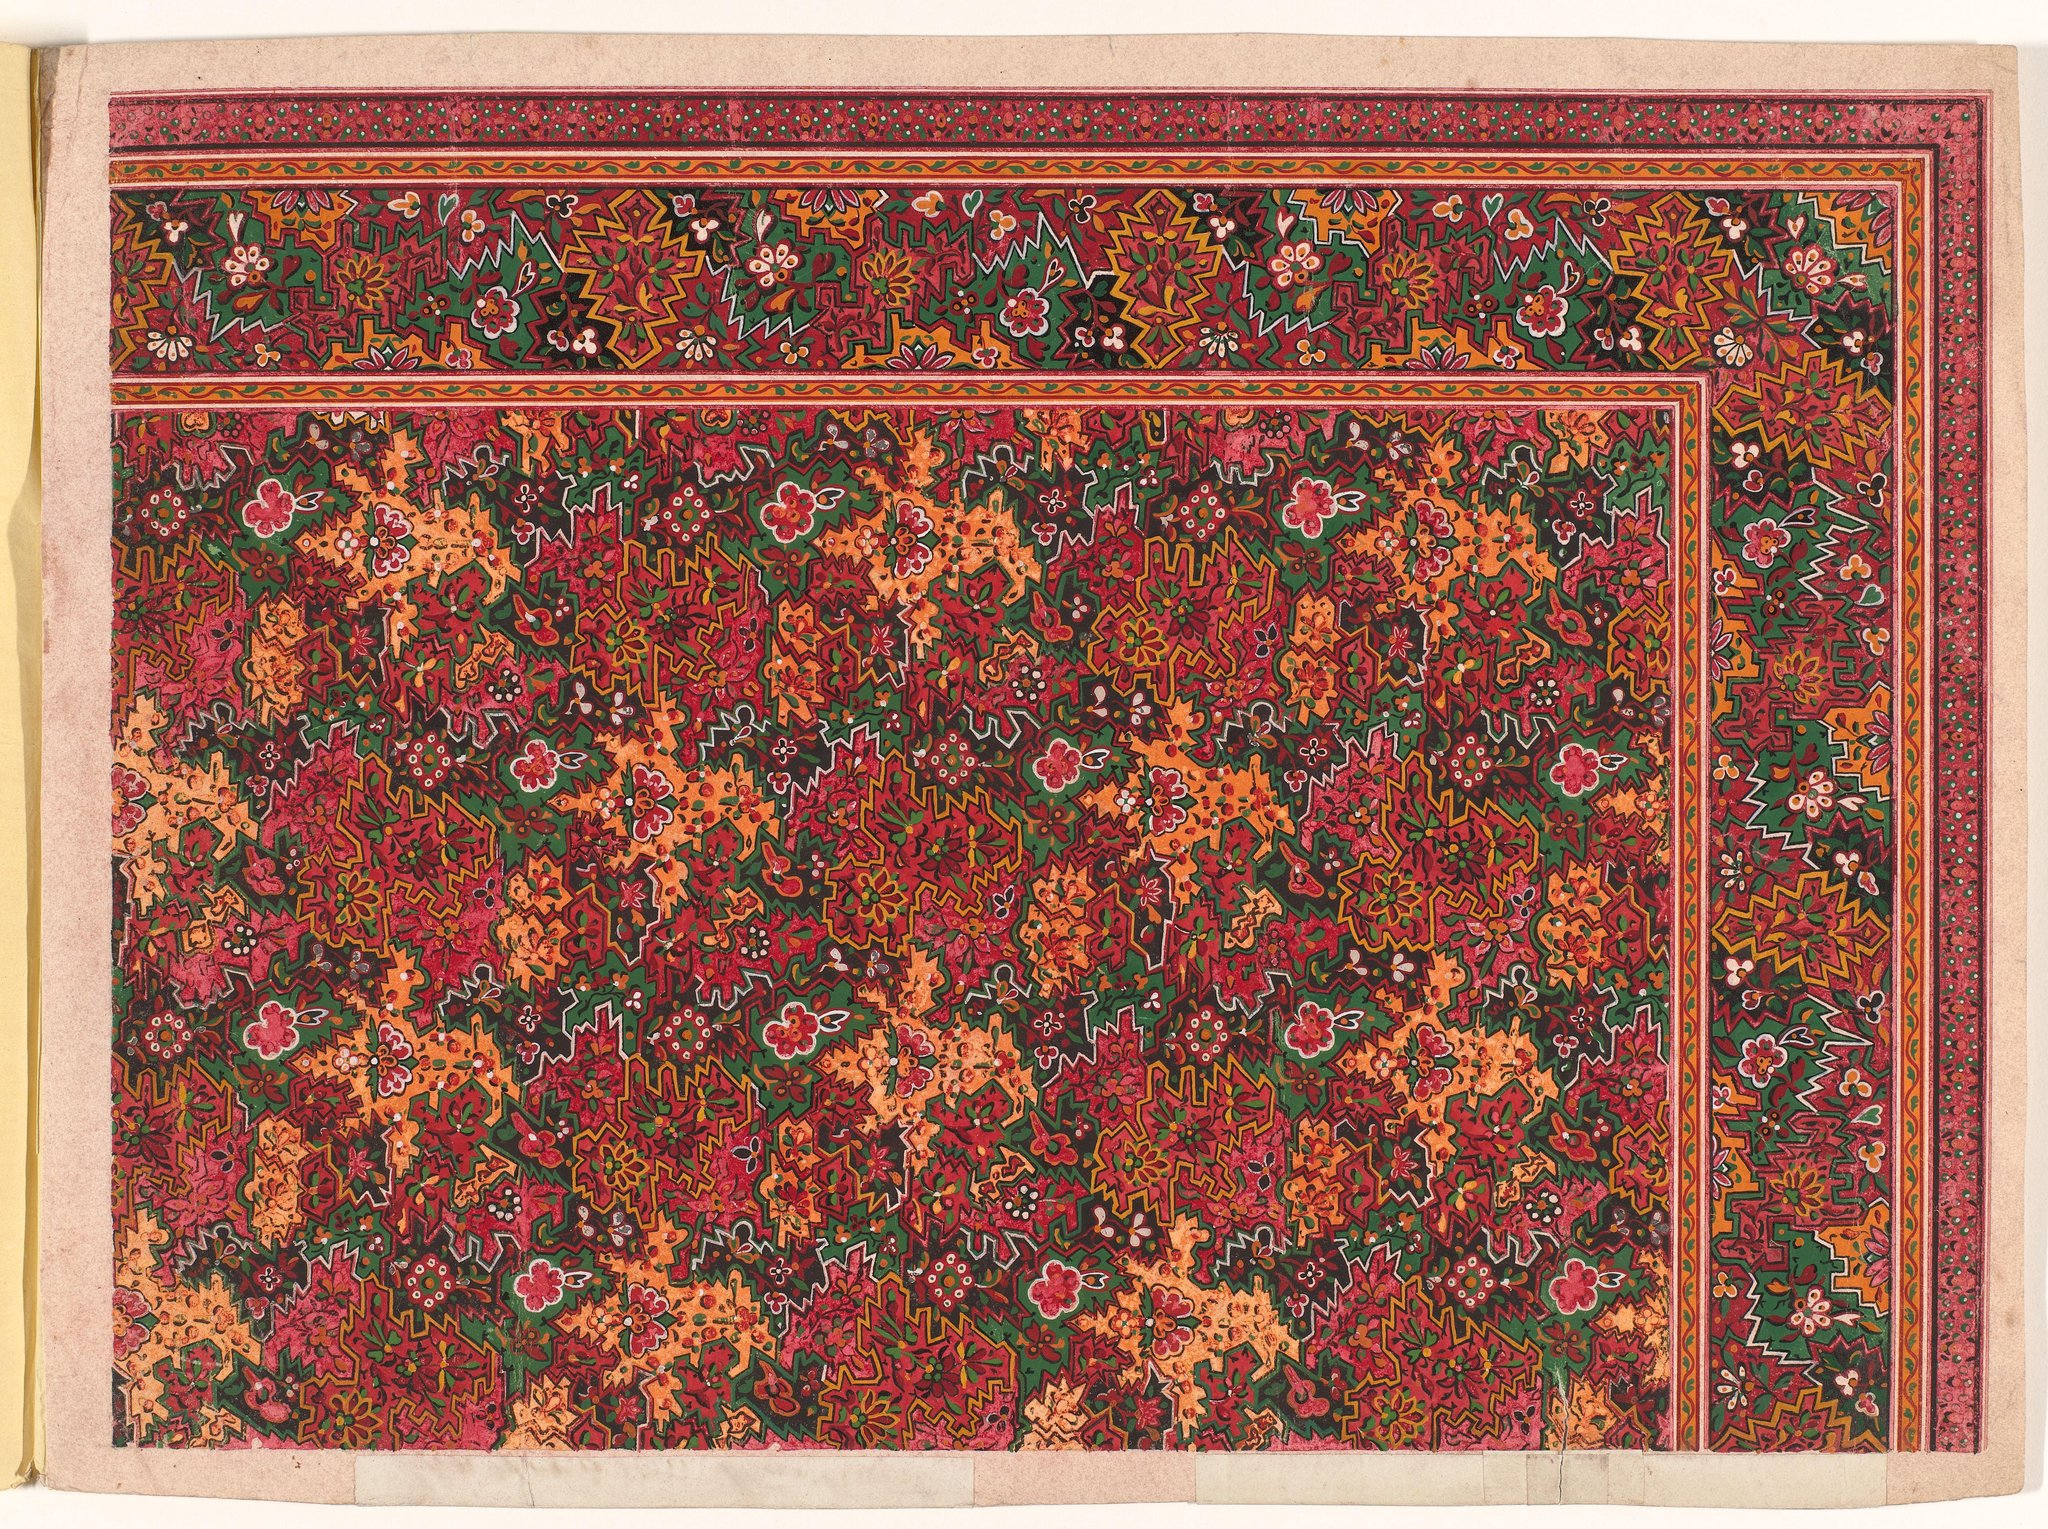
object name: drawing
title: Ontwerp voor een tapijt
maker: Anonymous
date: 1854-1864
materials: gouache, paper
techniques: brush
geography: deventer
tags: ornaments ~ art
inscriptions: retailer's mark: ‘JHS.’, inscription: ‘N 3.’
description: De presentatietekeningen BK-1971-77-1 t/m 86 zijn kopieën van de originele ontwerptekeningen. Ze werden gemaakt voor vertegenwoordigers van bijvoorbeeld magazijnen, die ze aan hun klanten konden tonen. De meeste tekeningen tonen een kwart van het dessin inclusief rand, middenpartij (de zogenaamde grond of fond) en centraal medaillon. Door het gebruik van spiegels kan de illusie van het gehele tapijt worden opgeroepen. Een deel van de tekeningen heeft een alfabetische opeenvolgende letter als kenmerk, de andere groep een cijfer.Waarschijnlijk is de reeks dessins met een letter eerder samengesteld dan de genummerde tekeningen.